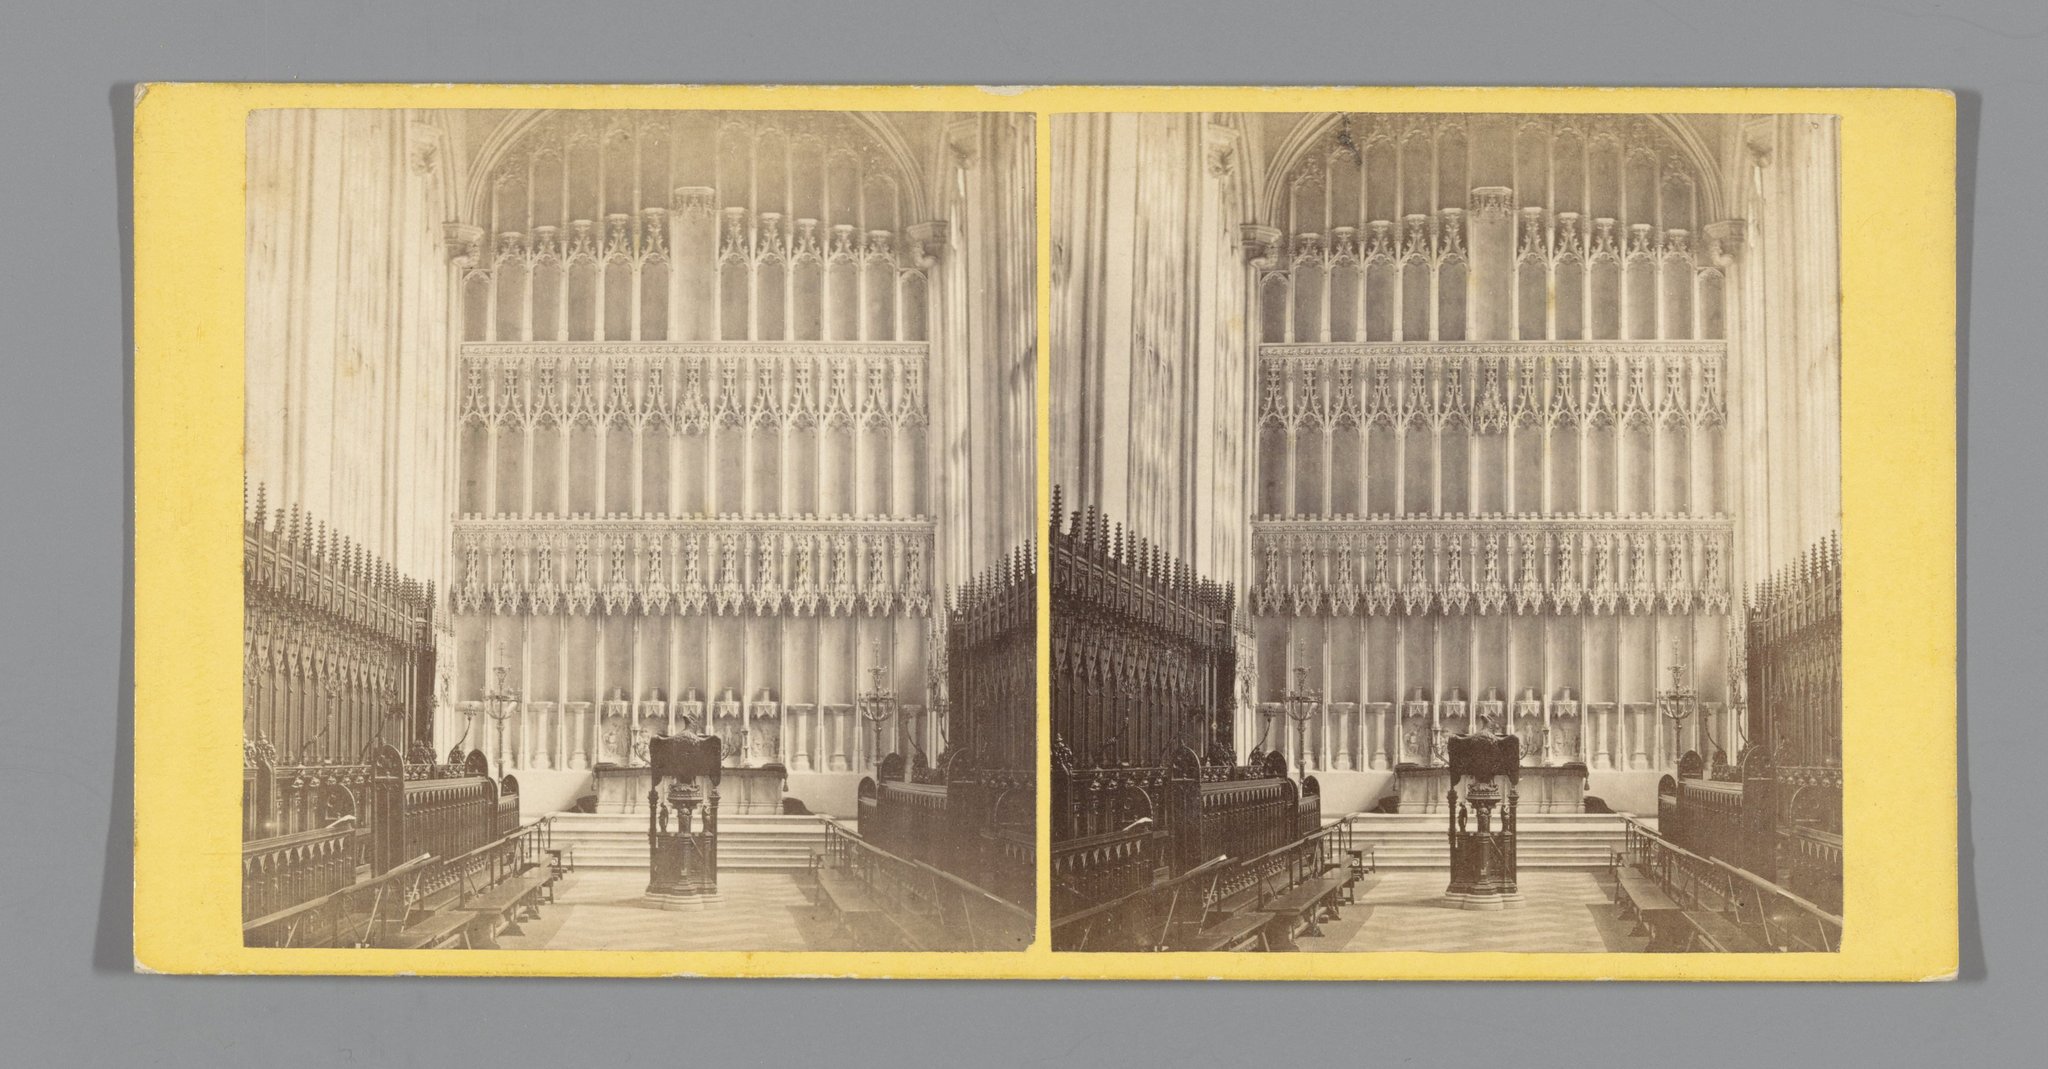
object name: stereograph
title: Interieur van de kapel van New College te Oxford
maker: alexander wilson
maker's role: fotograaf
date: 1850-1880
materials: cardboard, photographic support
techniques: albumen print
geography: new college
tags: parts of church interior: chapel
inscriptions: name: ‘Alexander Wilson, Photographer, Leamington.’, number: ‘No. 203.’